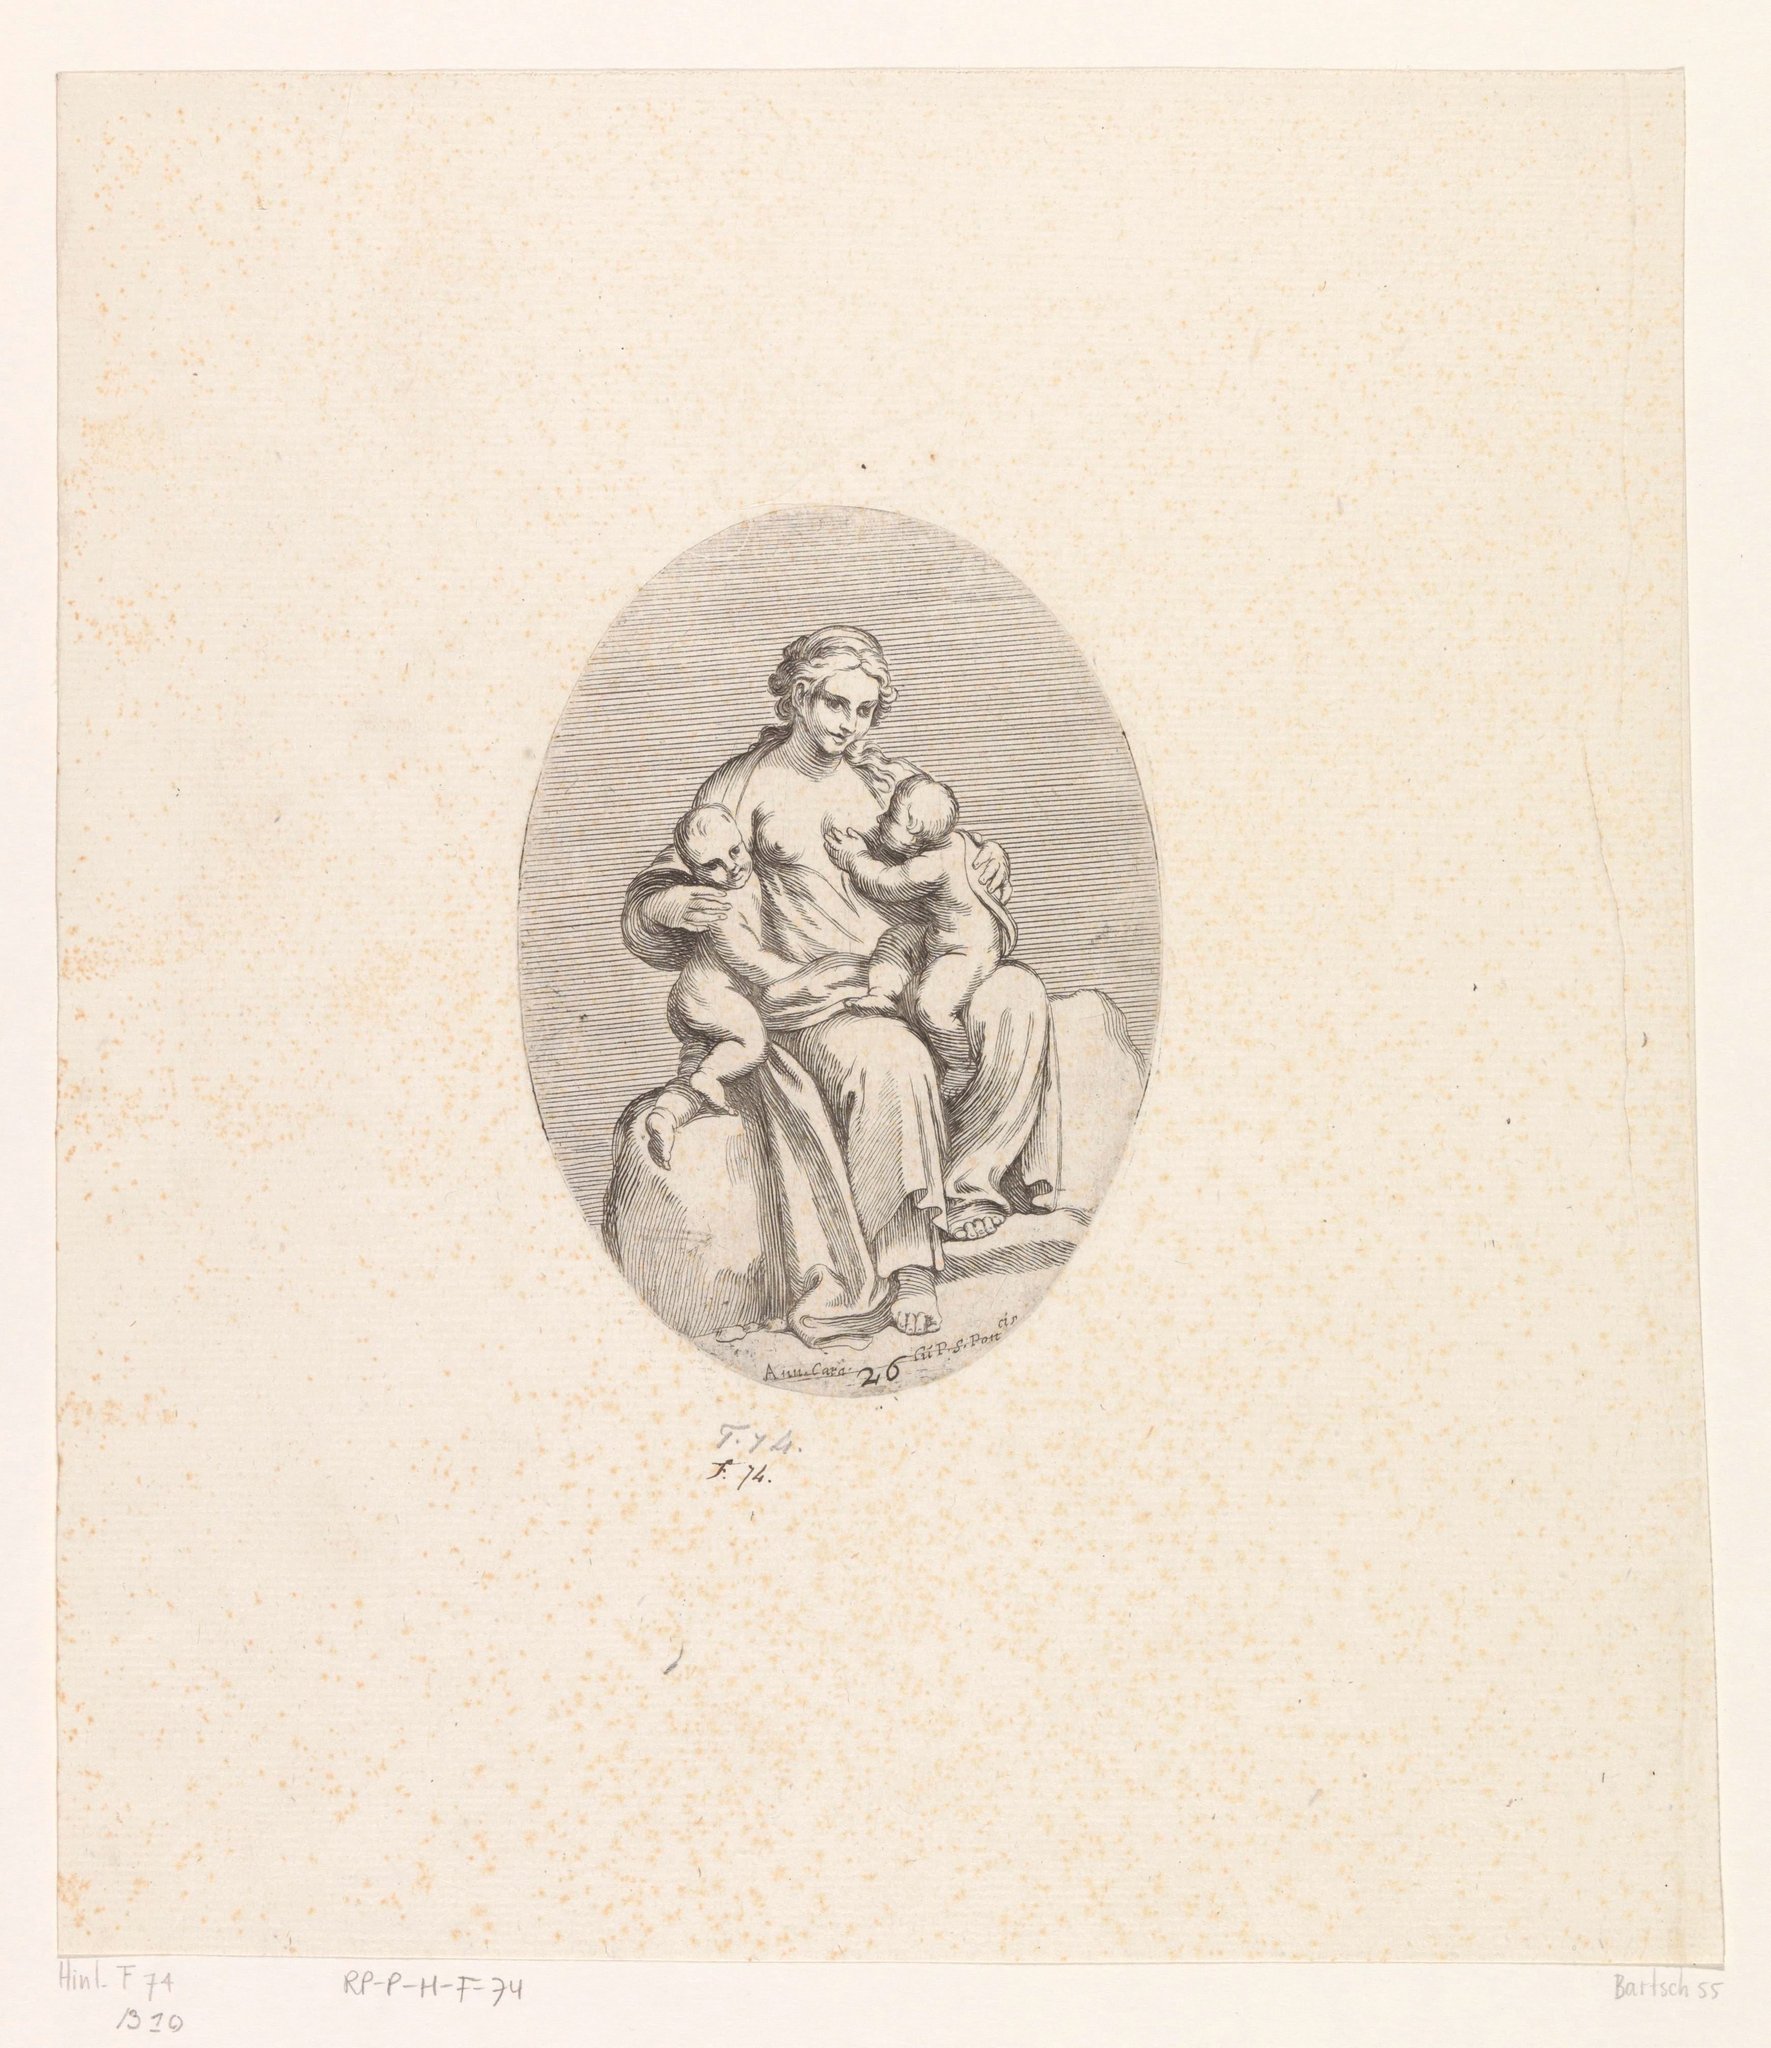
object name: print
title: Schilderingen in Palazzo Farnese te Rome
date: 1656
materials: paper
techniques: etching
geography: vatican city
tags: charity, 'caritas'; 'carità' (ripa) ~ one of the three theological virtues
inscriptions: collector's mark: Lugt 11, collector's mark: ‘Hinloopen’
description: Prent uit een reeks prenten met nummers van 1 tot en met 29 (sommige prenten hebben hetzelfde nummer), plus titelprent en opdracht, naar schilderingen in Palazzo Farnese te Rome. Deze prent maakte oorspronkelijk deel uit van liber nr. 22 van de Atlas van Rome, uit de collectie Hinloopen. In dit album waren een aantal prentreeksen naar bekende zeventiende eeuwse frescoseries bijeengebonden. In 1709 heeft Schijnvoet op last van de burgemeesters van Amsterdam de collectie herordend. De prenten uit liber 22 kwamen terrecht in Schijnvoet boek nr. 10. De laatst gedateerde reeks in het album is gedateerd 1691. Het album moet dus na deze datum gebonden zijn. De band is in de Rijksakademietijd uit elkaar gehaald. De marges van de prenten zijn bij het opbergen in het Rijksprentenkabinet vaak drastisch afgesneden. Van een aantal series waren de prenten teruggeslagen om in het album te passen. (Zie: Waals, Jan van der. De prentschat van Michiel Hinloopen. 's-Gravenhage: SDU uitgeverij, 1988, pp. 173-174.)